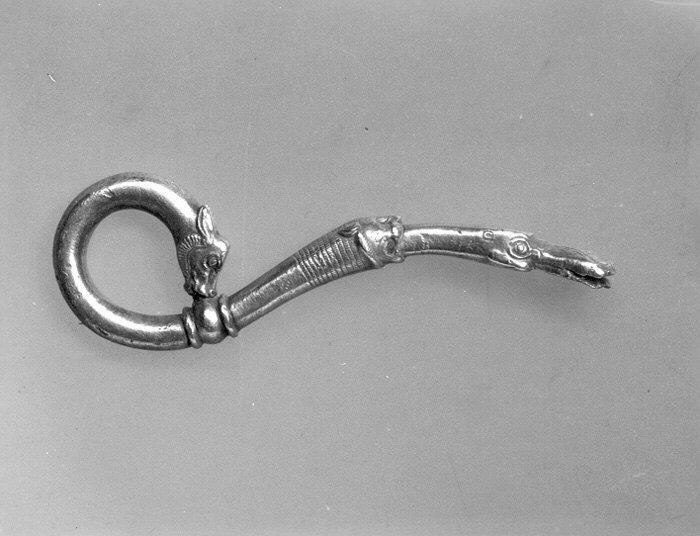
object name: handle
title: Handle, possibly for a spoon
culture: achaemenid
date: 500-401 BCE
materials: silver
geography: iran (?)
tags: animals